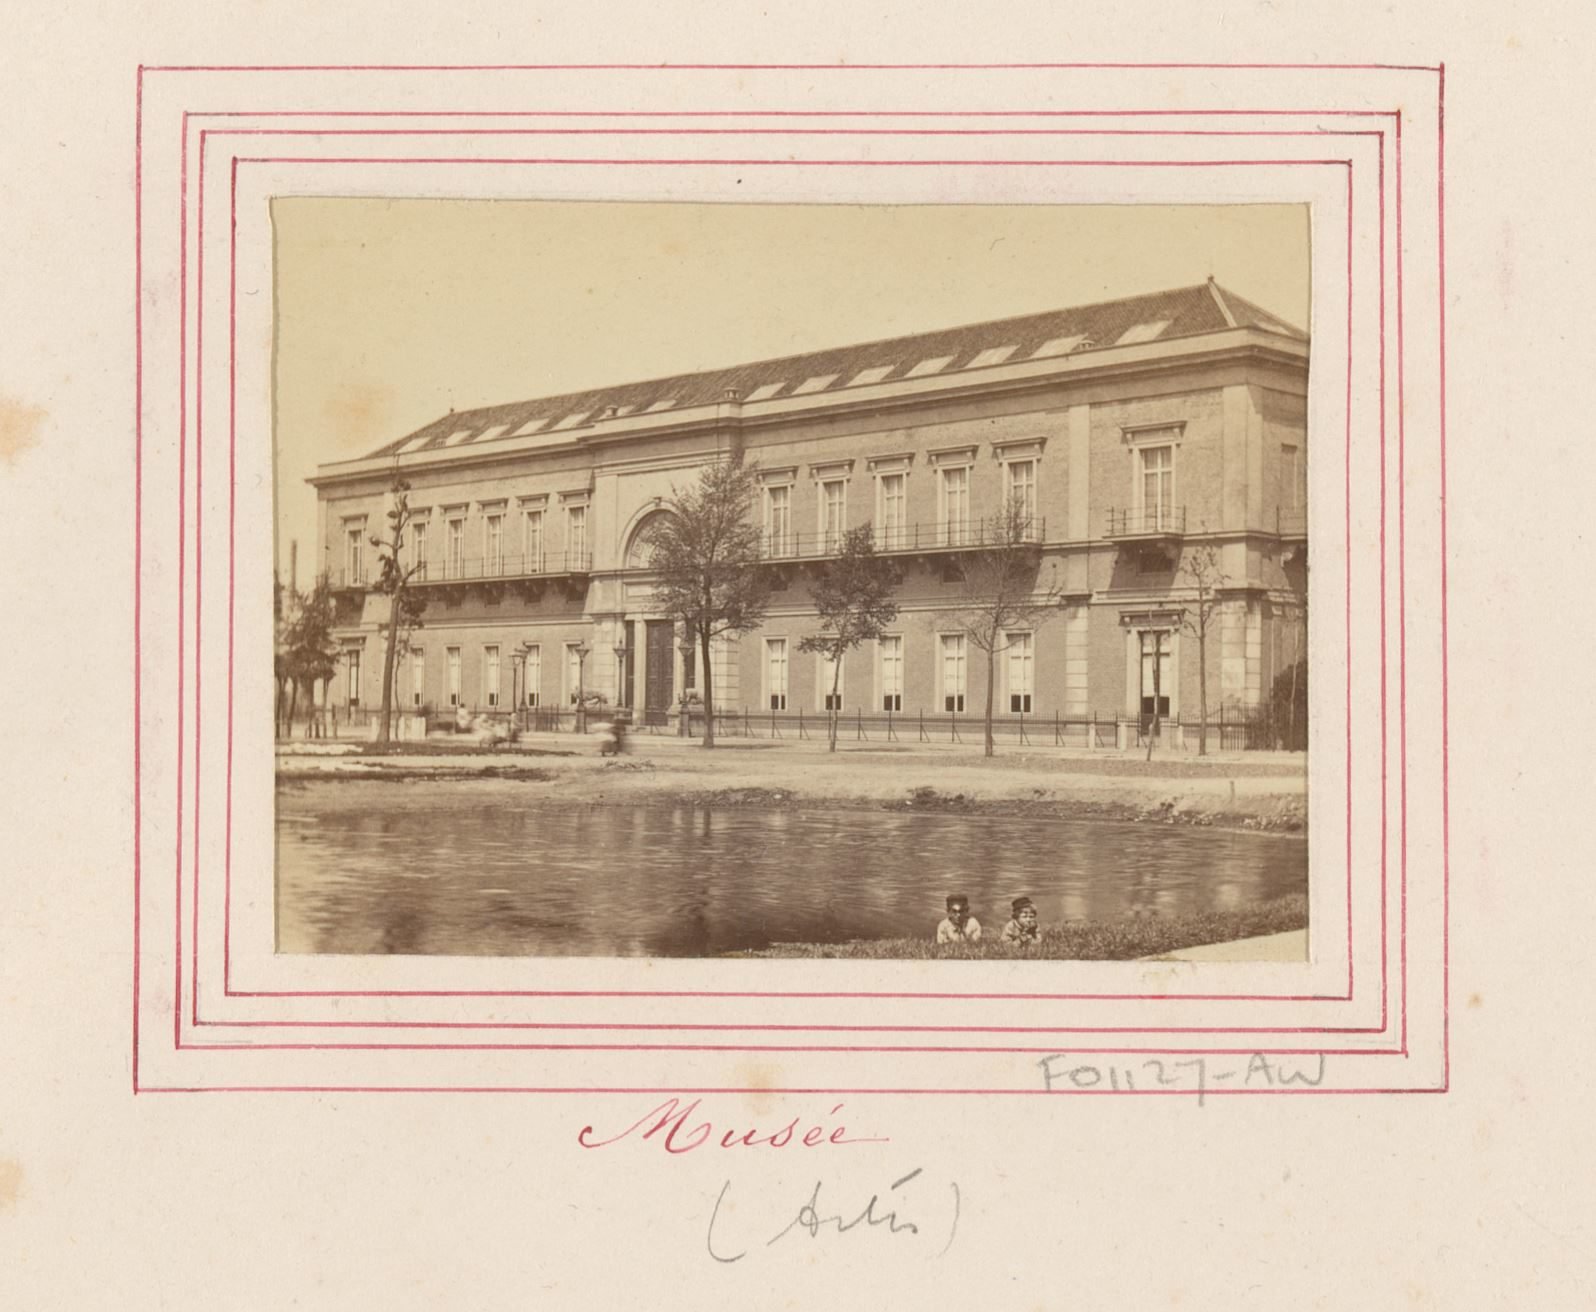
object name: photograph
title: Groote Museum aan de Plantage Middenlaan in Amsterdam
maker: Anonymous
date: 1870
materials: photographic support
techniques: albumen print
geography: plantage middenlaan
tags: permanent exhibition, museum, façade (of house or building)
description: Onderdeel van Album met foto's en litho's van bezienswaardigheden in Noord- en Zuid-Hollandse steden, schilderijen en klederdrachten.